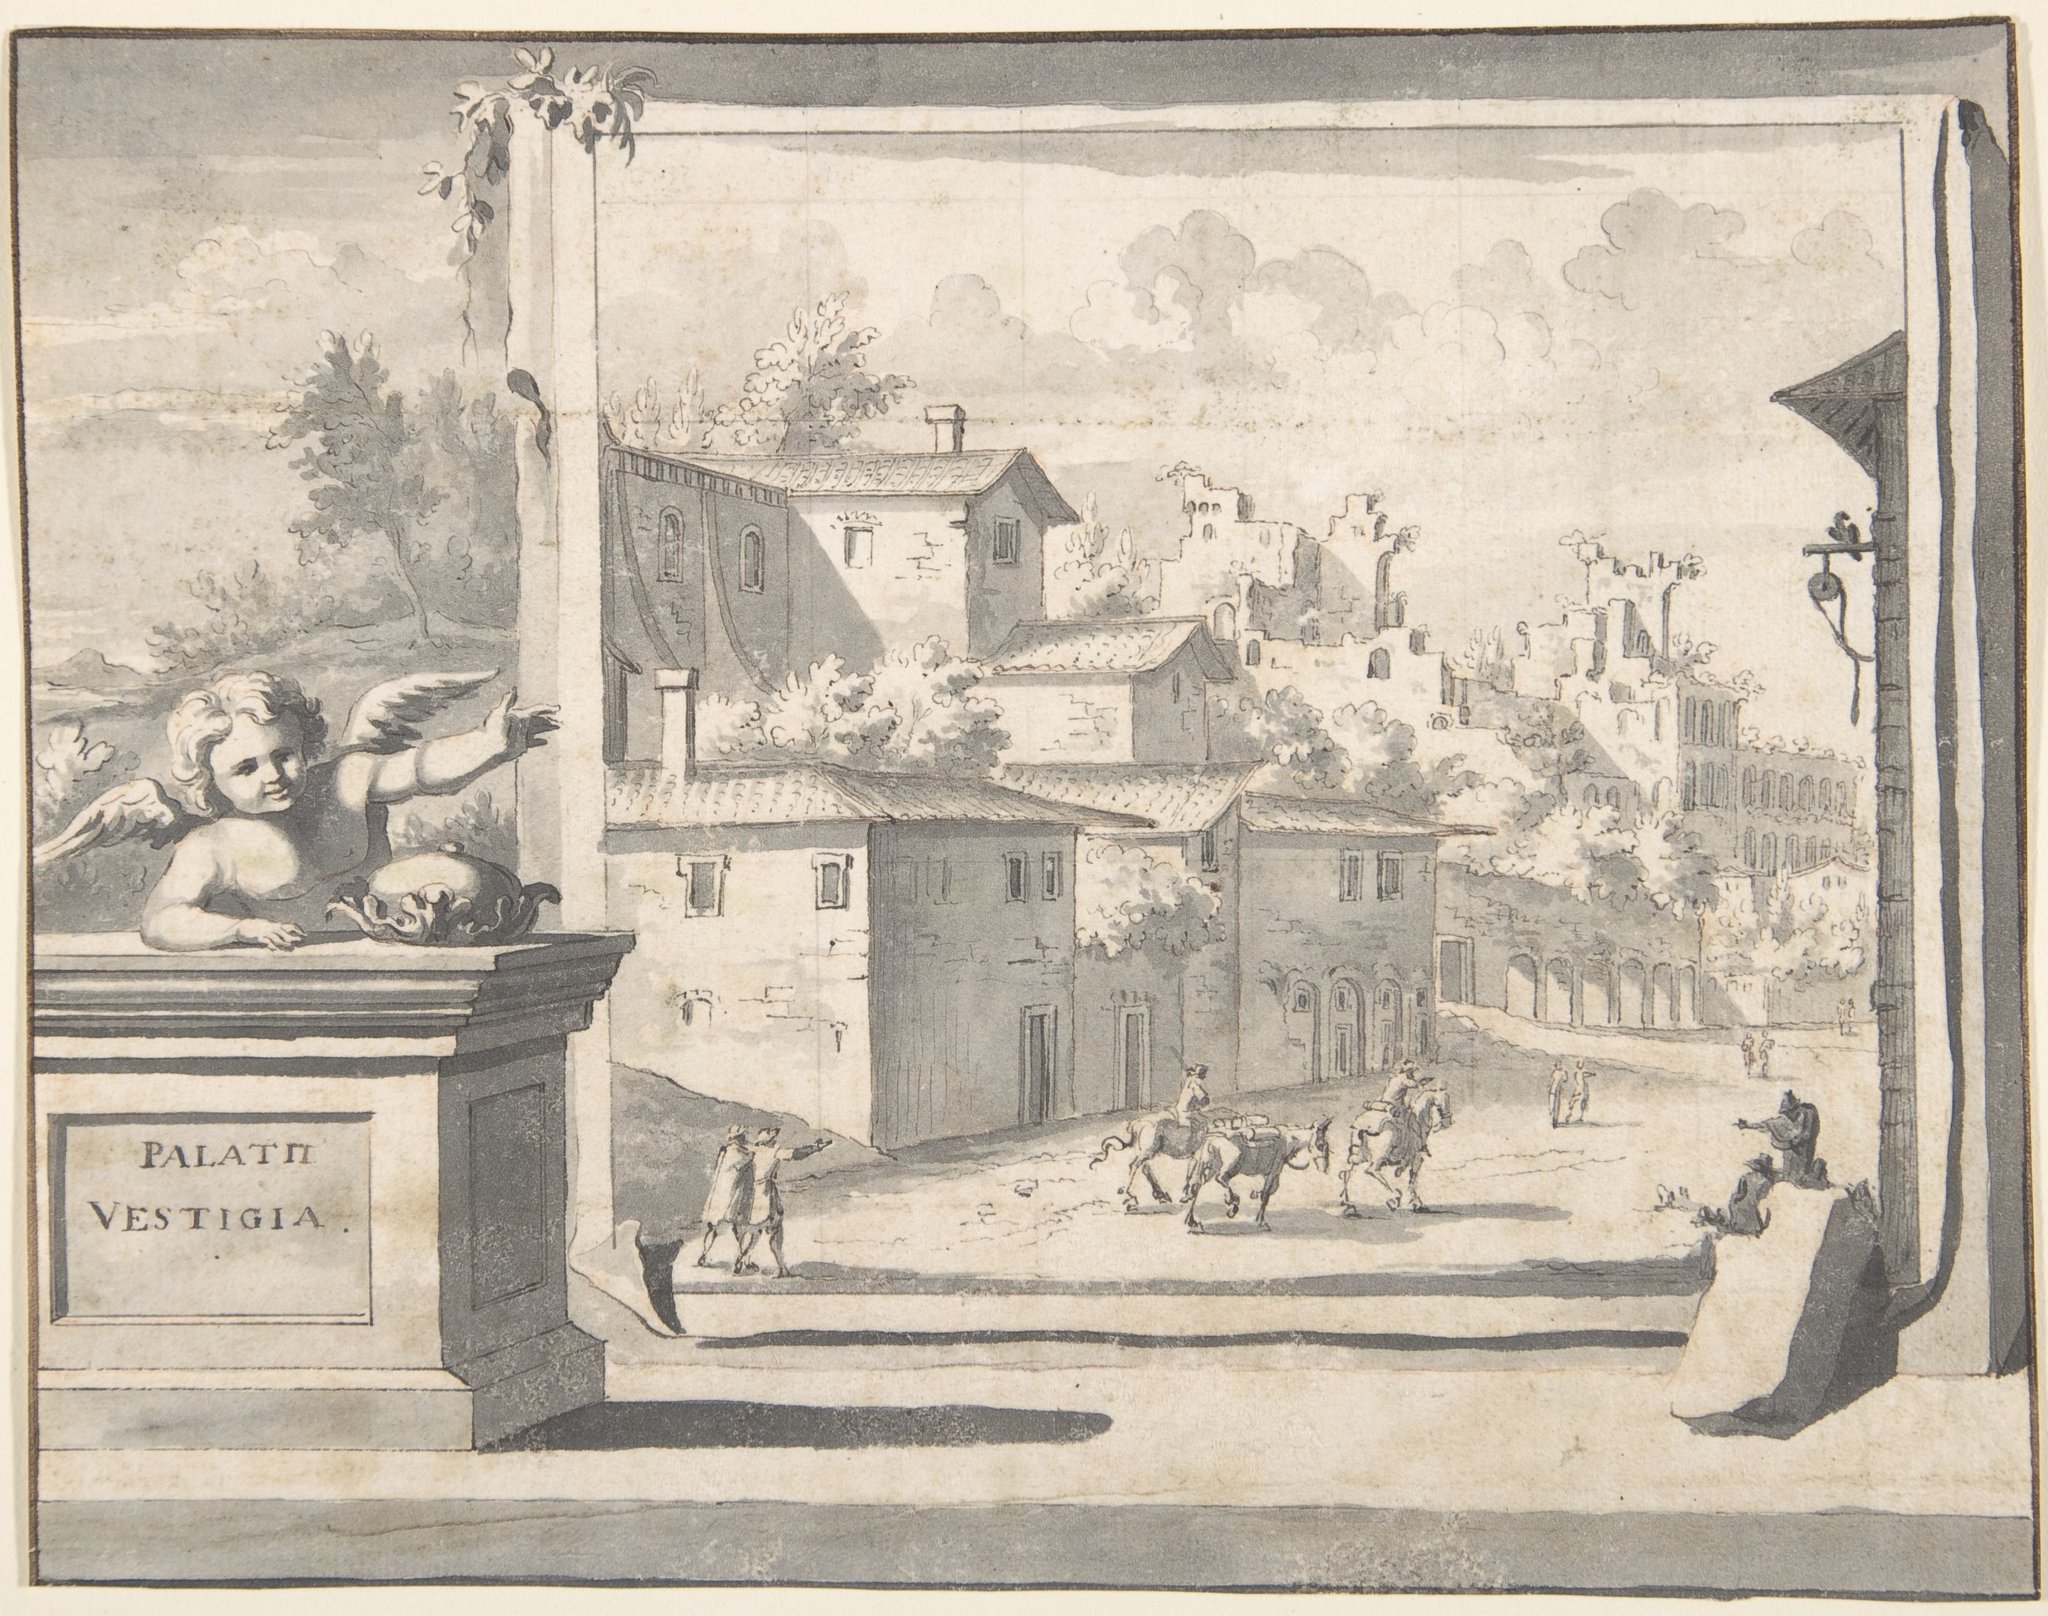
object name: drawing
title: View of the Ruins of the Palatine Hill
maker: jan goeree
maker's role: artist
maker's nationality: dutch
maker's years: 1670-1731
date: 1704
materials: chalk, ink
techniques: brush, pen, drawing, wash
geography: italy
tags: buildings,ruins,men,horses